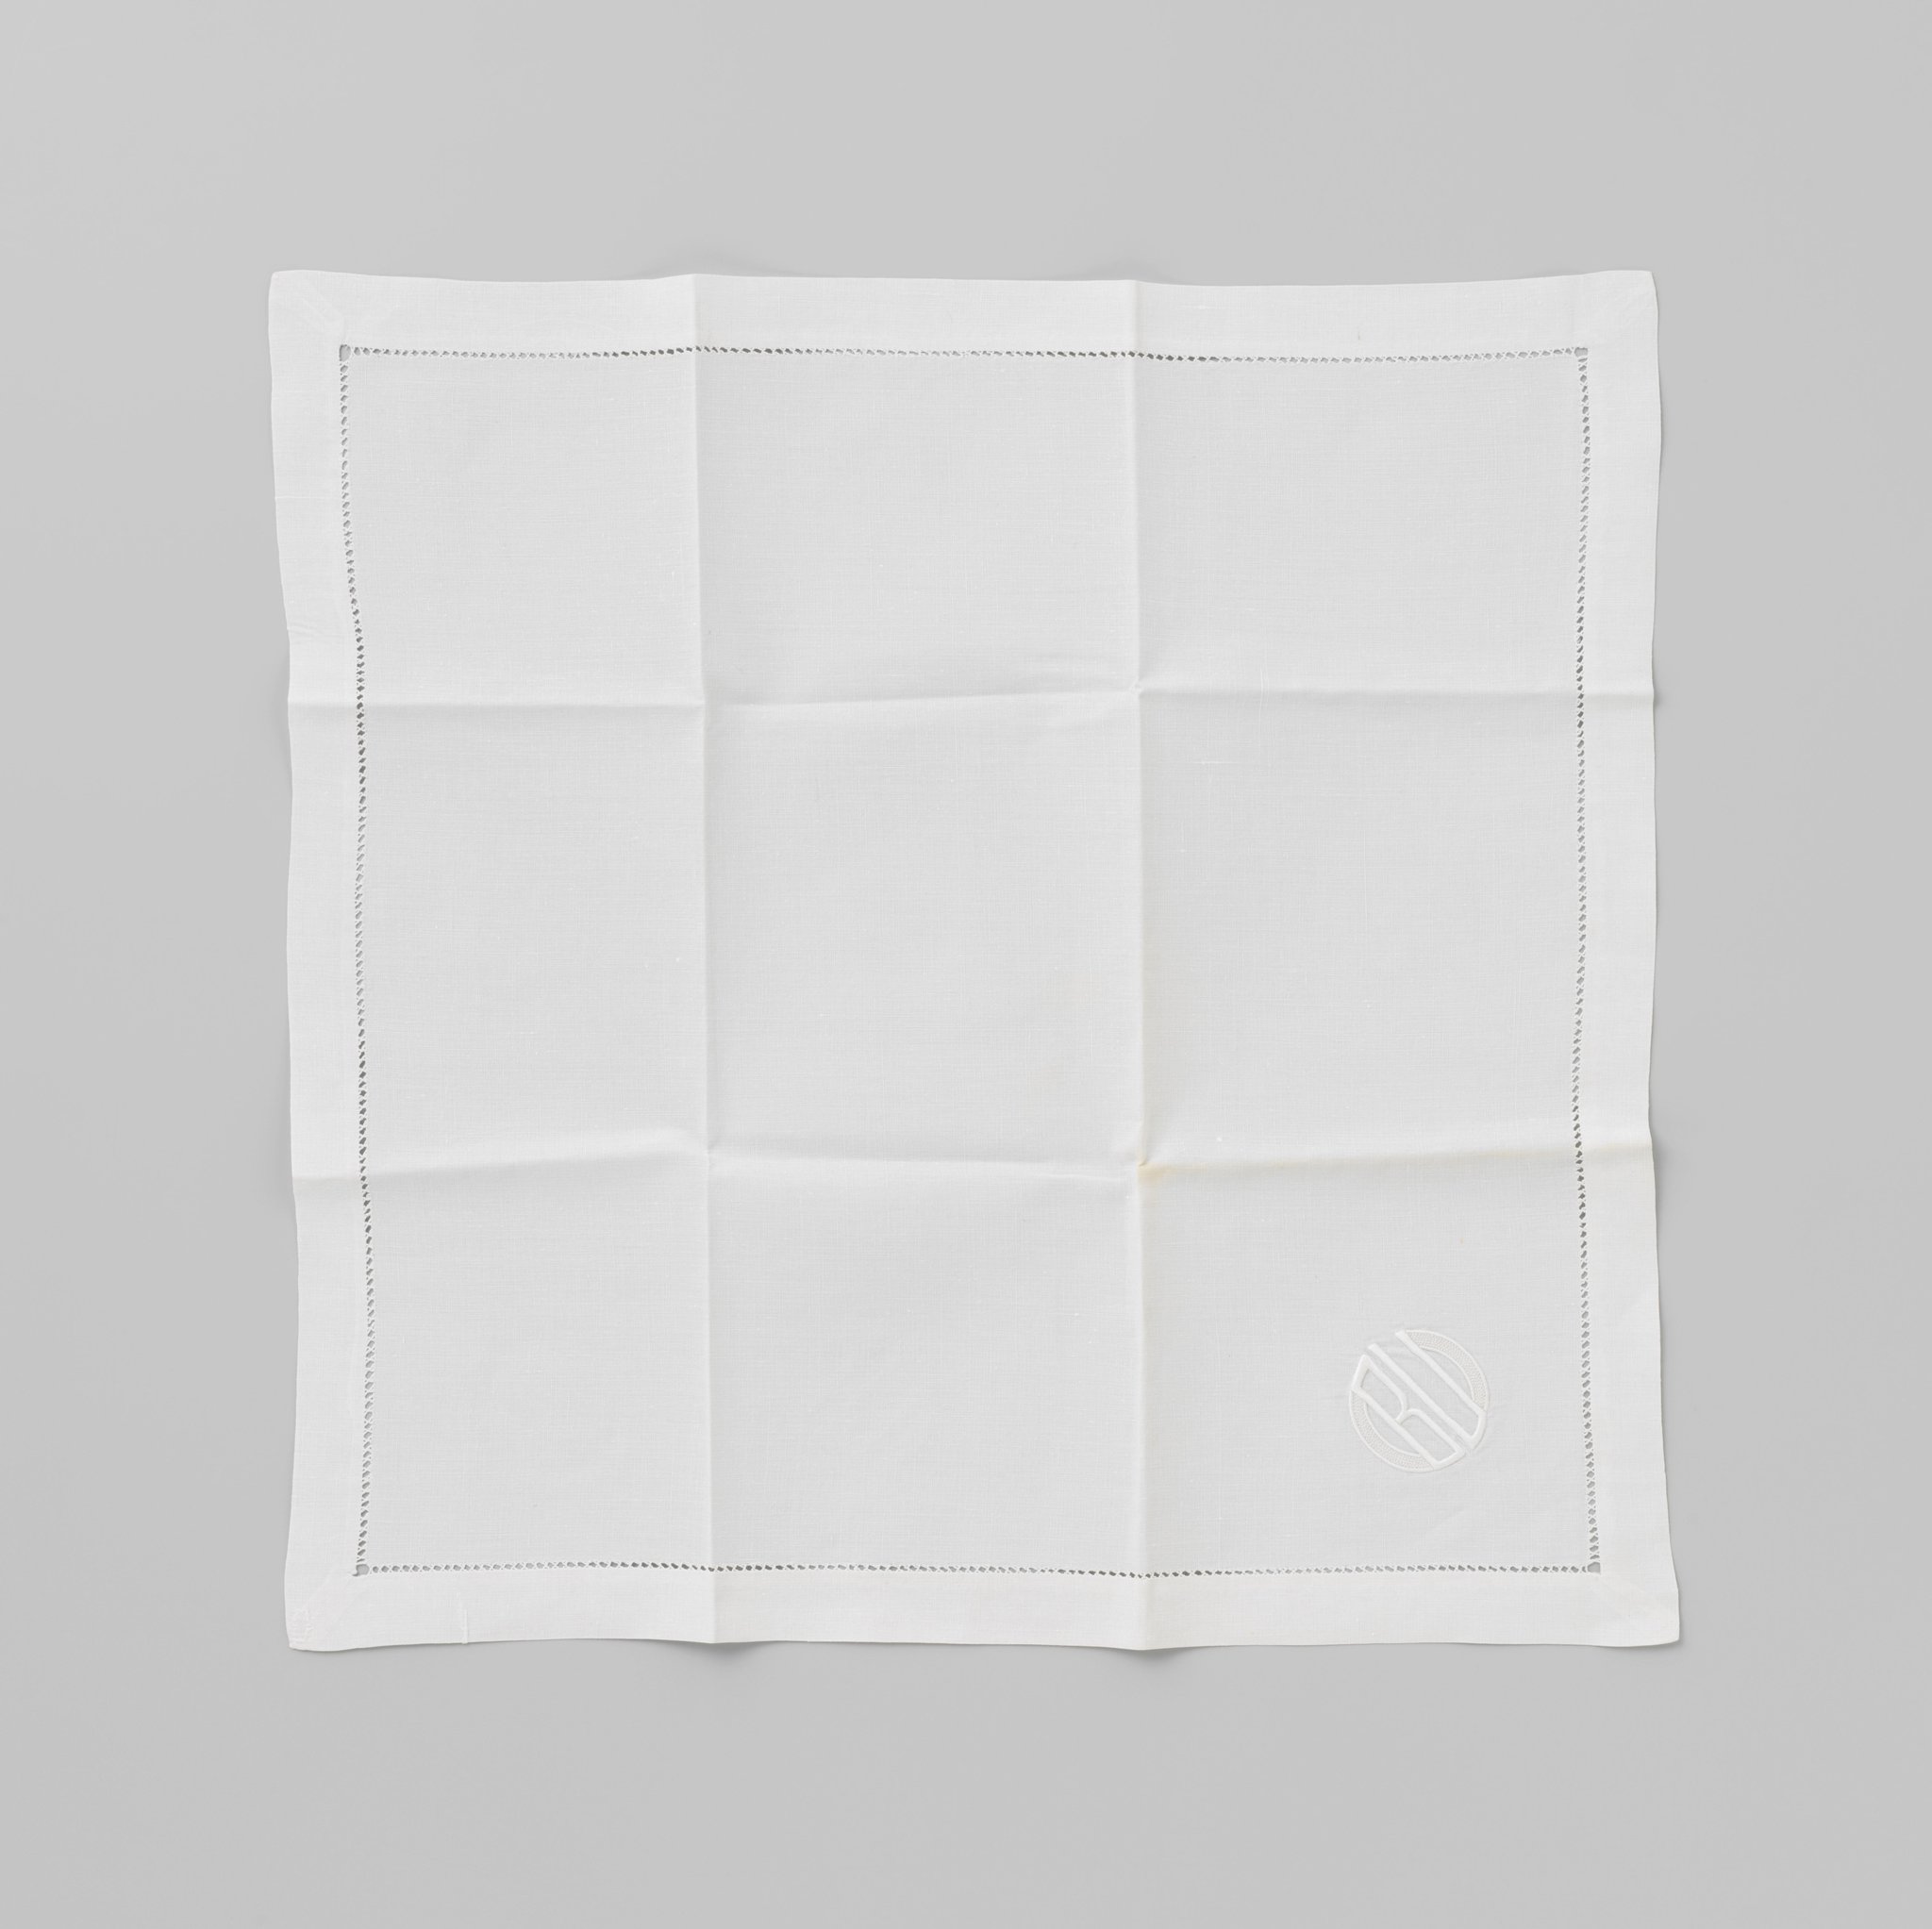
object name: napkin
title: Servet van linnen met de geborduurde initialen BU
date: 1935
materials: linen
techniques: embroidered, weave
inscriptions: initials: ‘BU’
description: Servet van linnen in platbinding, met opengewerkte zomen en de geborduurde initialen BU (Brusse-Urtebise).